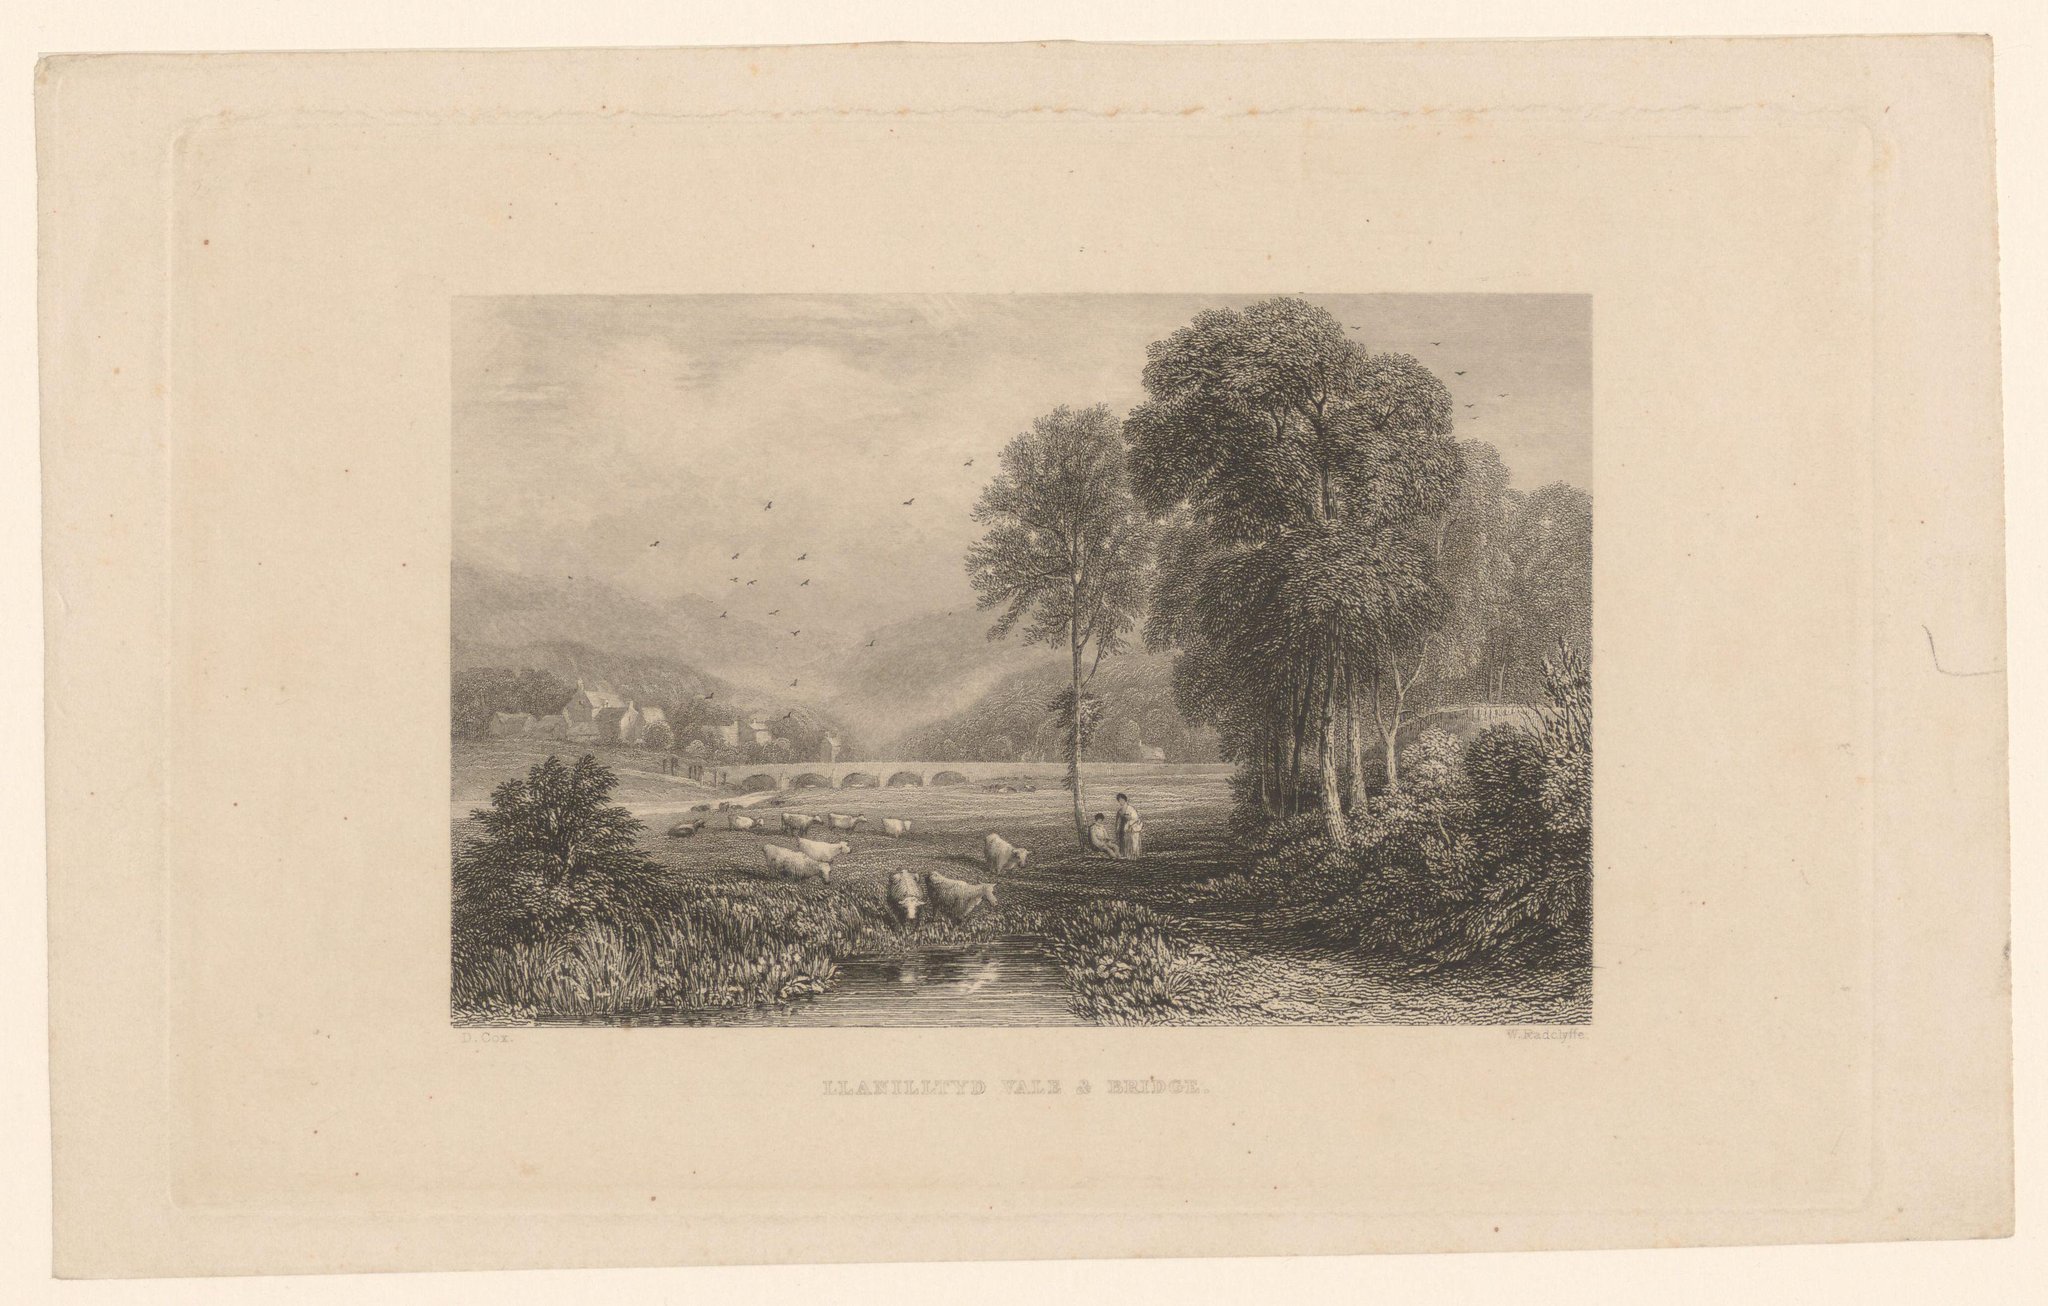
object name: print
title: Heuvellandschap met koeien en een brug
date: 1806-1855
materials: paper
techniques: engraving, etching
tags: dale, valley (+ landscape with figures, staffage), landscape with bridge, viaduct or aqueduct (+ city(-scape) with figures, staffage)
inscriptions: collector's mark: Lugt 2228